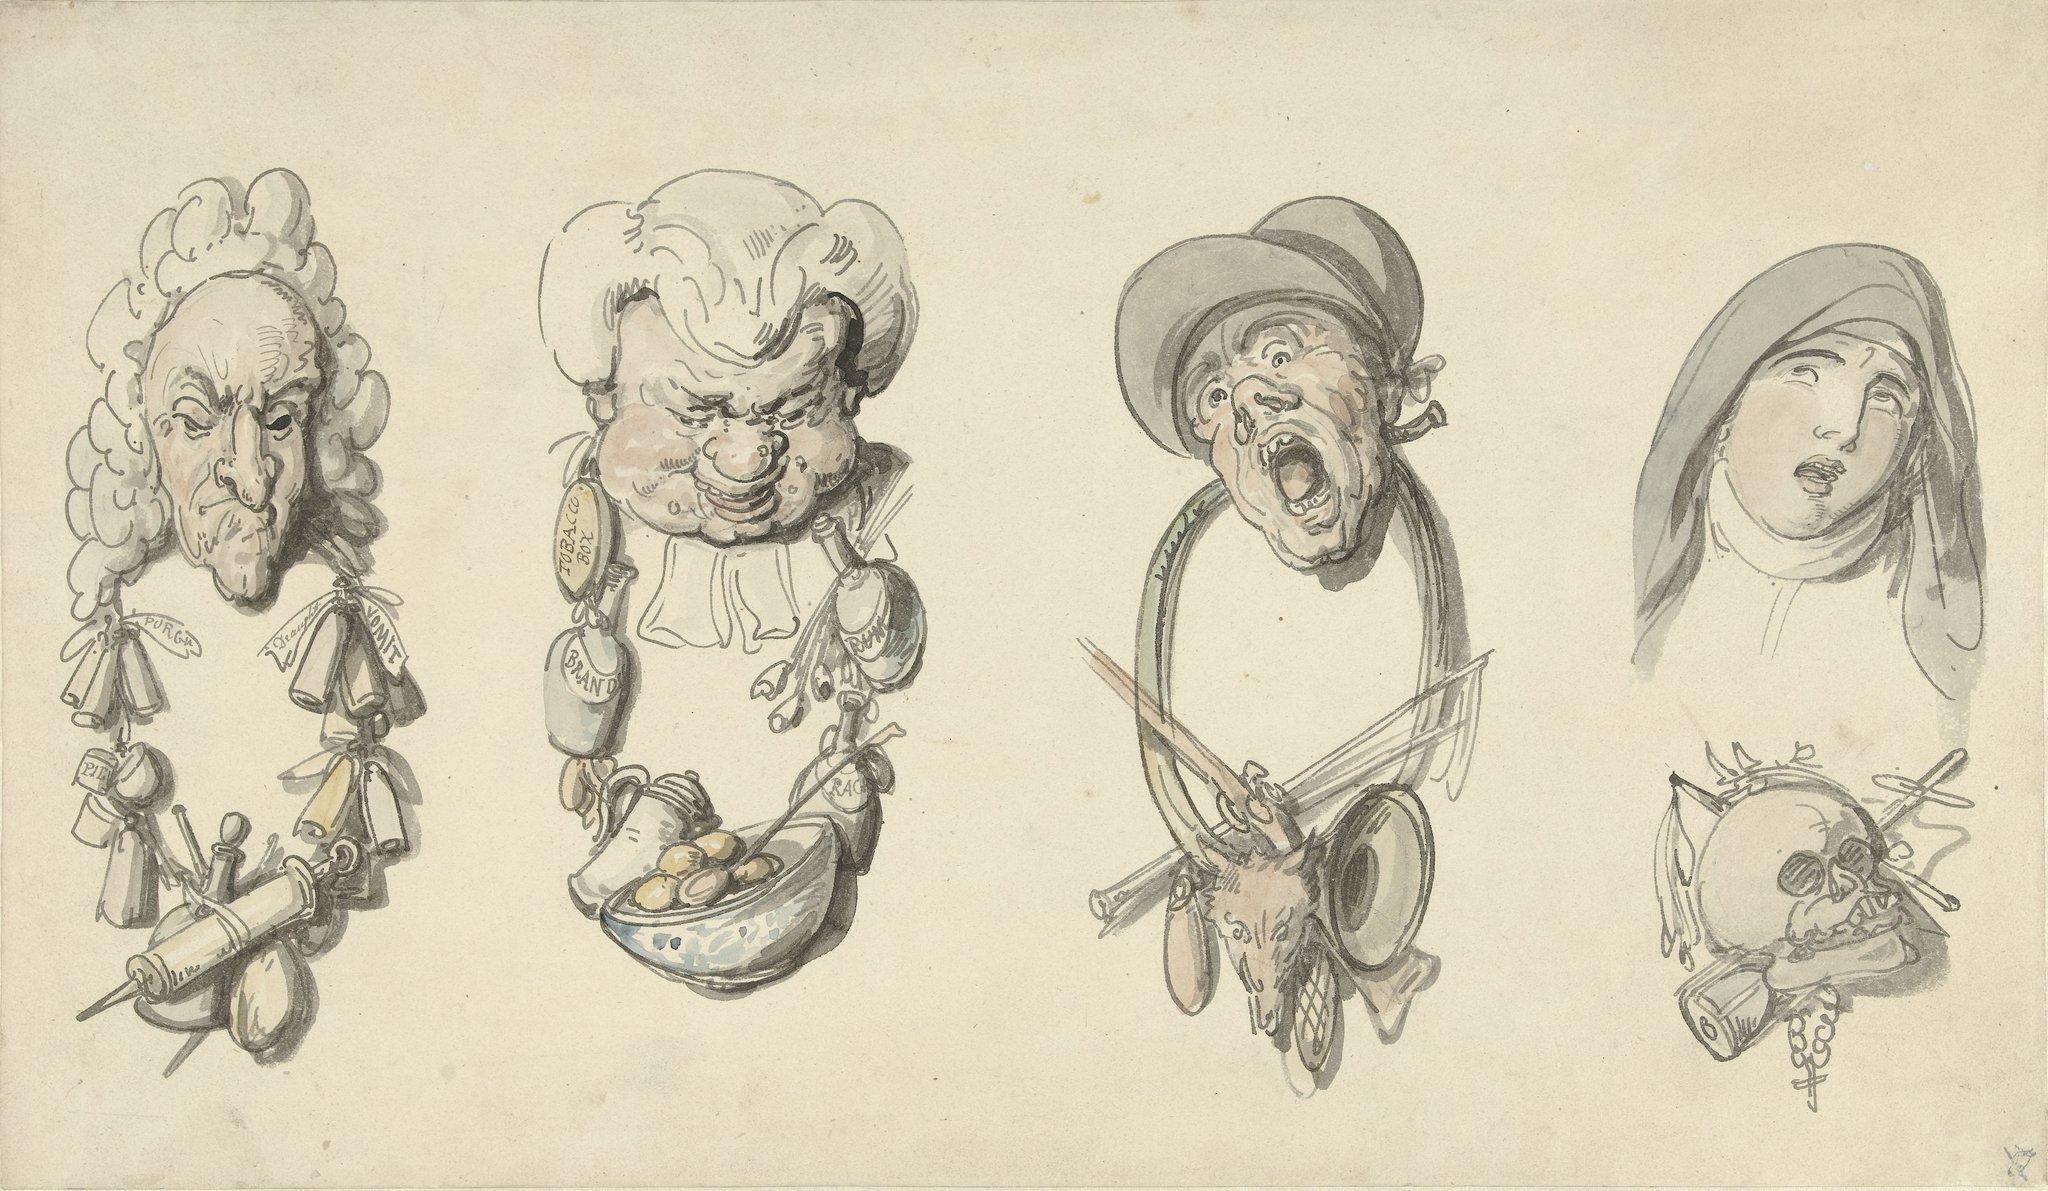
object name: drawing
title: Vier karikaturale koppen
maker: thomas rowlandson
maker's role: draughtsman, print maker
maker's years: 1756-1827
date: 1795-1800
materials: ink, paper, watercolor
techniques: brush, pen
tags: caricatures (human types)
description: De vier ontwerpen maken onderdeel uit van een reeks van achttien karikaturale koppen die Rowlandson in prent brengt.